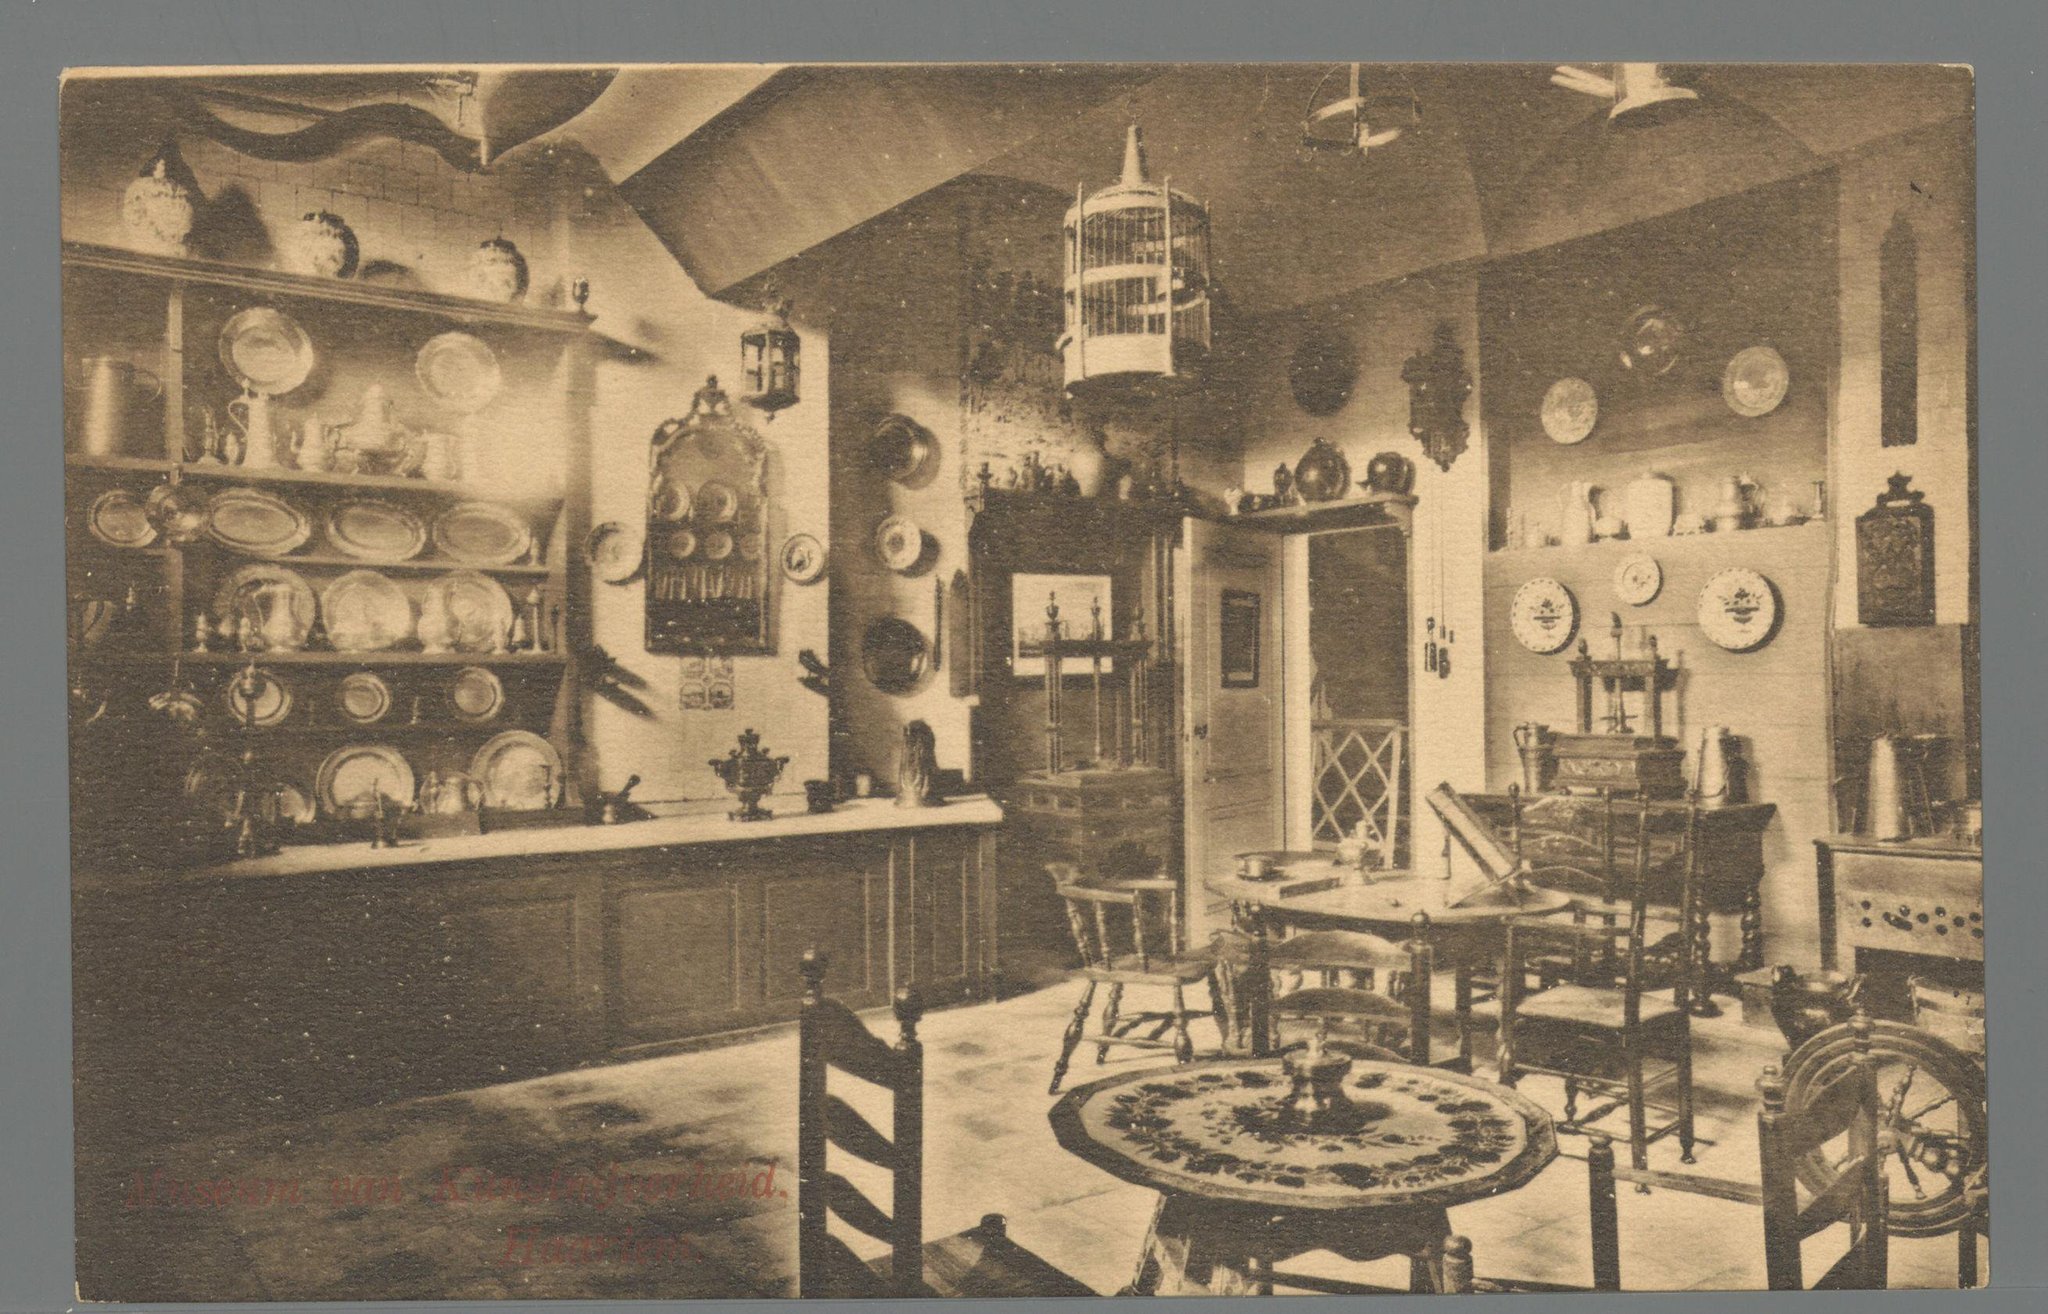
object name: ansichtkaart, prentbriefkaart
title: Museum van Kunstnijverheid, Haarlem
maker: Anonymous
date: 1906-1930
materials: cardboard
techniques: photograph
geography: haarlem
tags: interior of the house, permanent exhibition, museum, haarlem